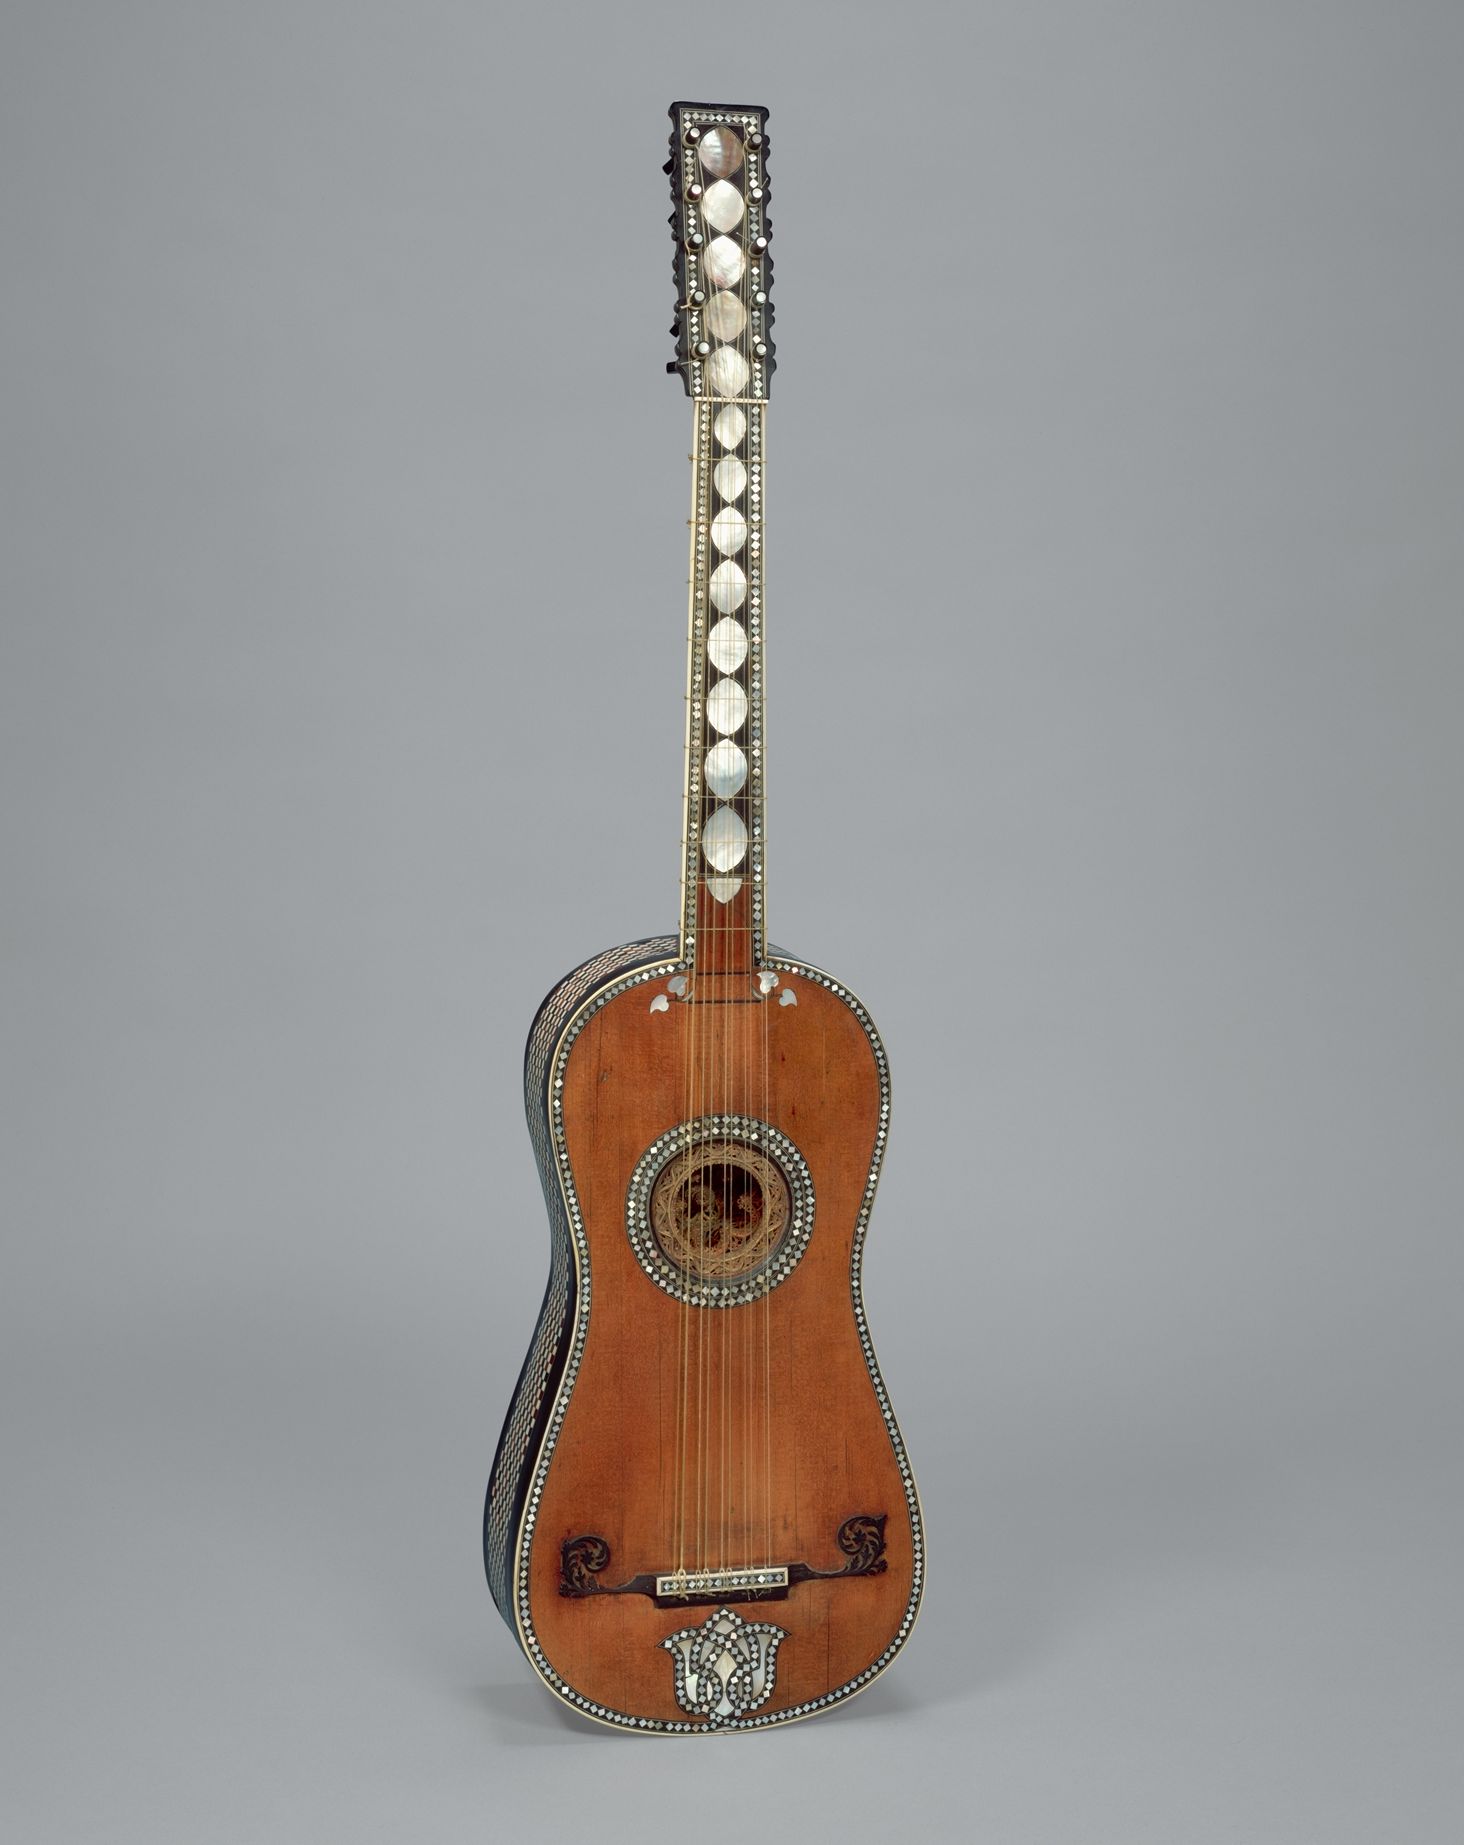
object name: guitar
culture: italian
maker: giacomo (jacob) ertel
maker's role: maker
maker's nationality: german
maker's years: 1646-1711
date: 1667-1700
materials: bone, wood, ivory, mother of pearl, parchment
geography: italy